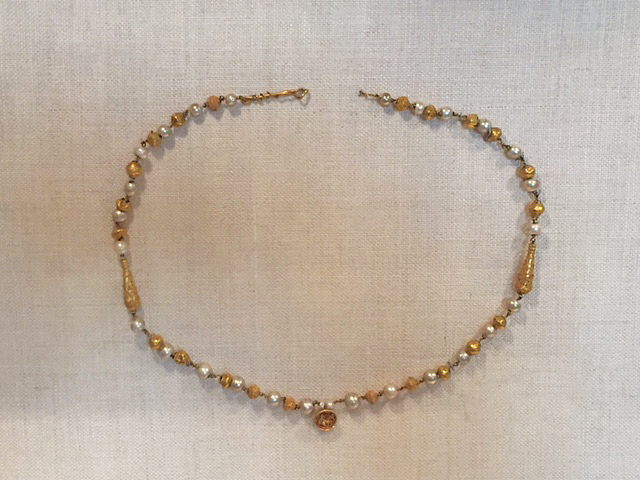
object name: necklace with pendant of eros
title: Pearl and gold necklace with pendant of Eros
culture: east greek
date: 330-300 BCE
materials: gold, pearl